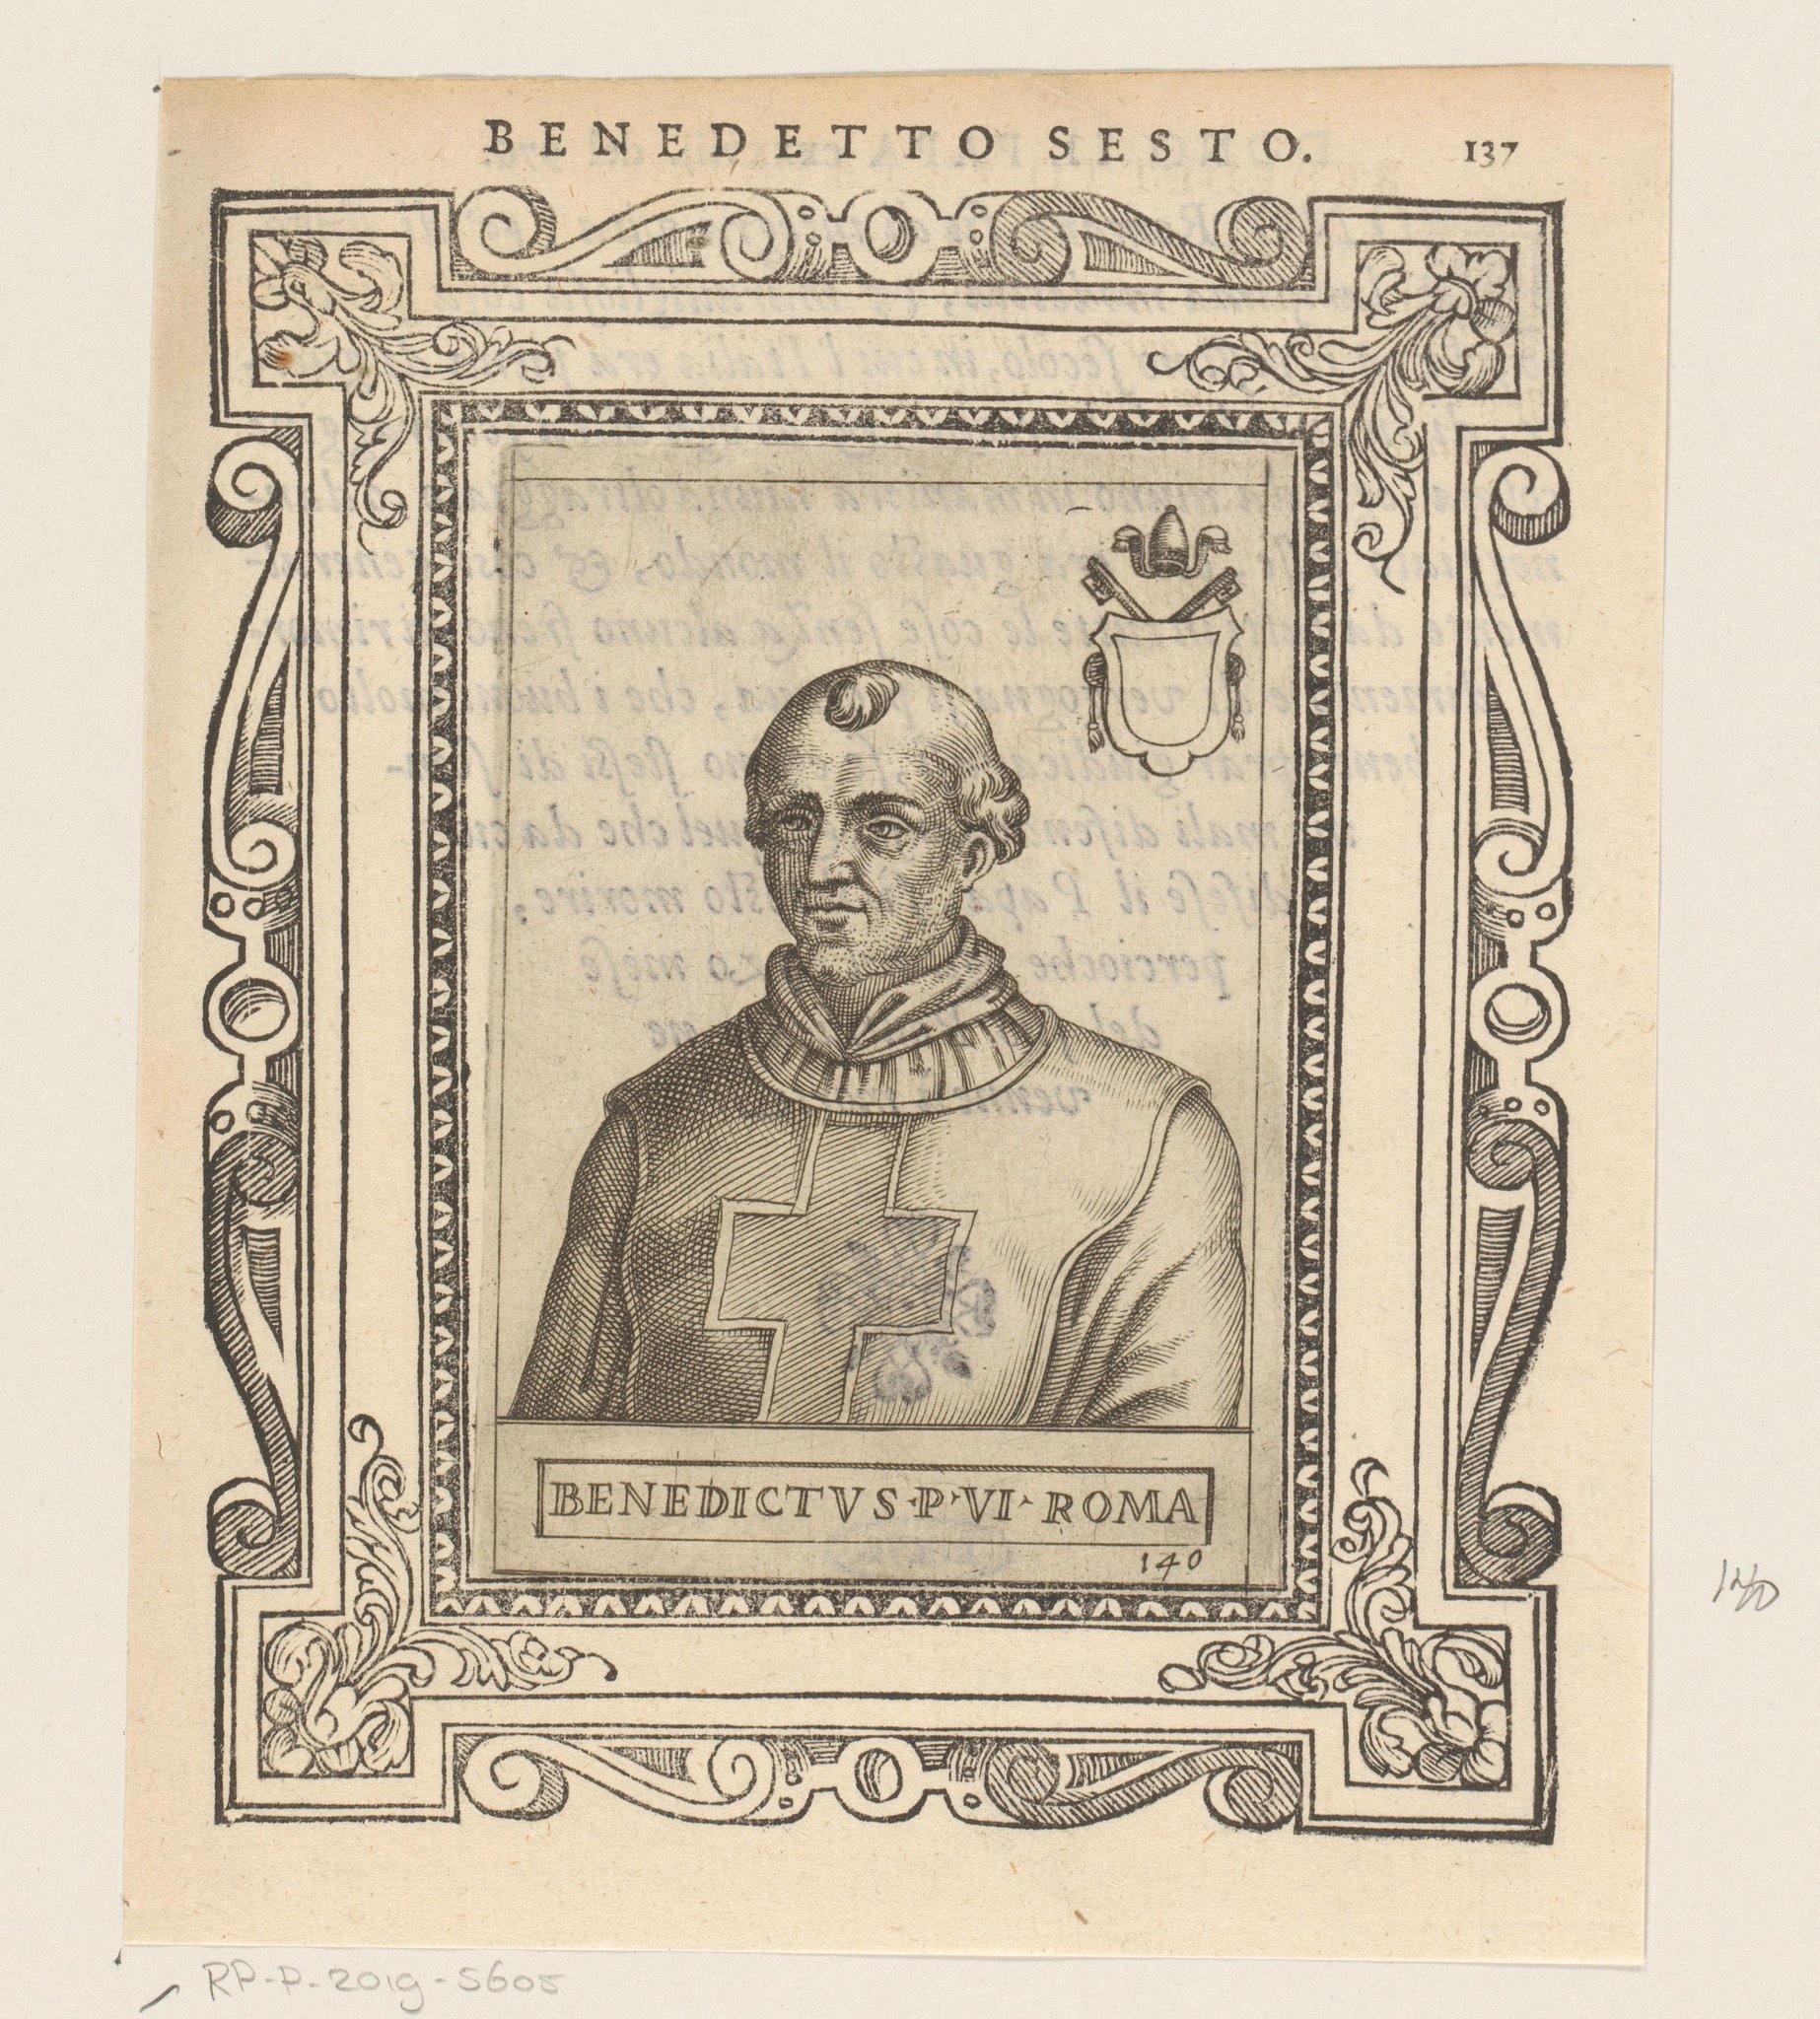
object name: print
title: Portret van paus Benedictus VI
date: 1587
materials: paper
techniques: engraving, letterpress printing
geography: rome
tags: rome, historical persons, pope, armorial bearing, heraldry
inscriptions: collector's mark: Lugt 2228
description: Prent uit: Ciccarelli, Antonio. Le vite de Pontefici di Antonio Ciccarelli (...). Rome: Domenico Basa, 1587. Prent voor het eerst verschenen in: Cavalieri, Giovanni Battista de'. Pontificum romanorum effigies (...). Rome: Domenico Basa en Francesco Zanetti, 1580. Prent ook gebruikt in latere publicaties.